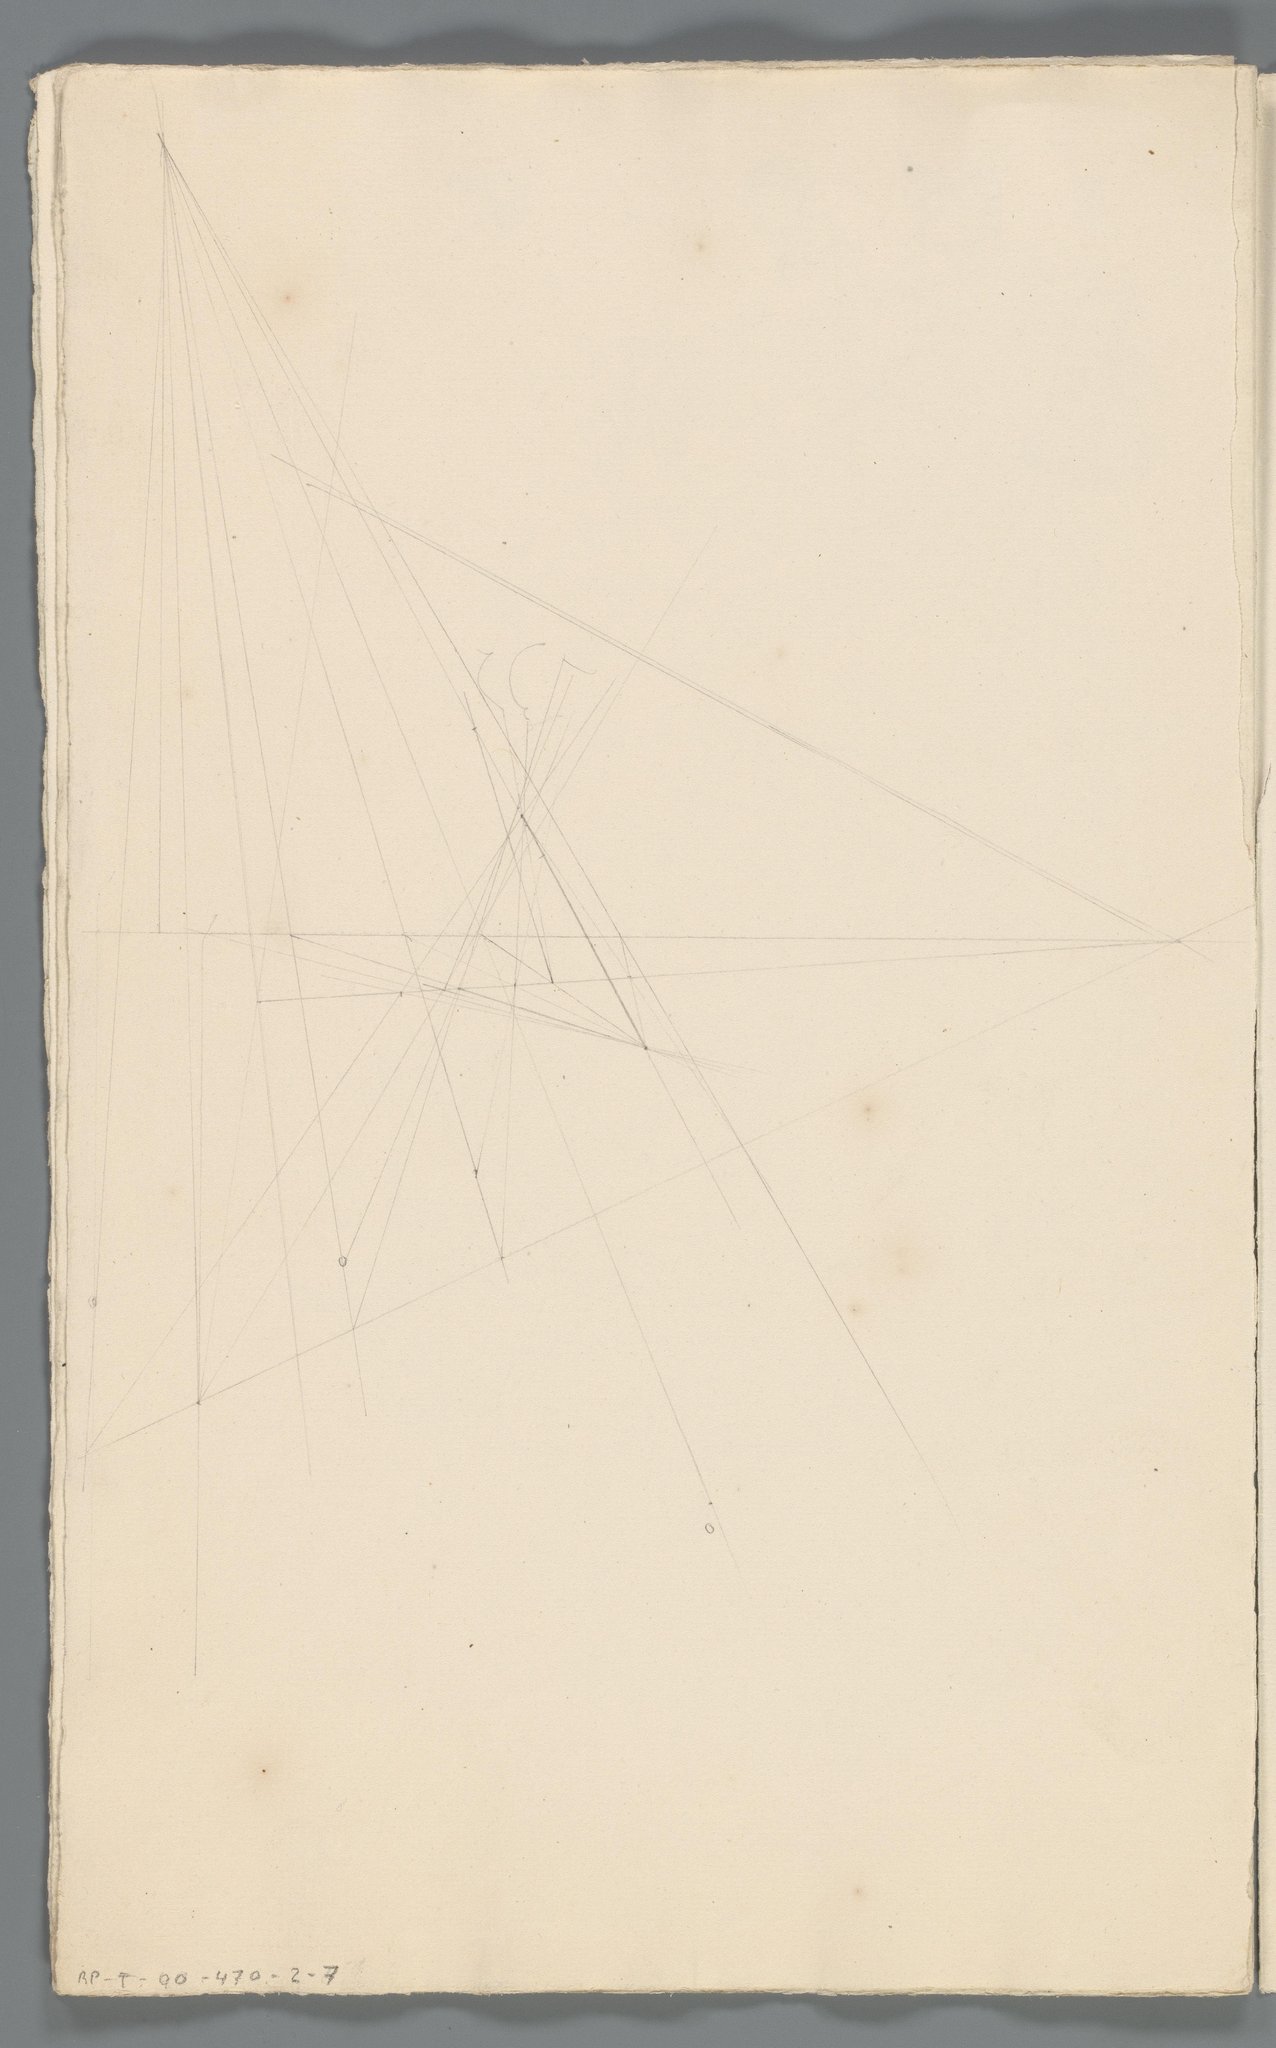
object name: drawing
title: Schets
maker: jacobus everhardus josephus van den berg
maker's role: draughtsman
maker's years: 1802-1861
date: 1812-1861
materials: paper, pencil